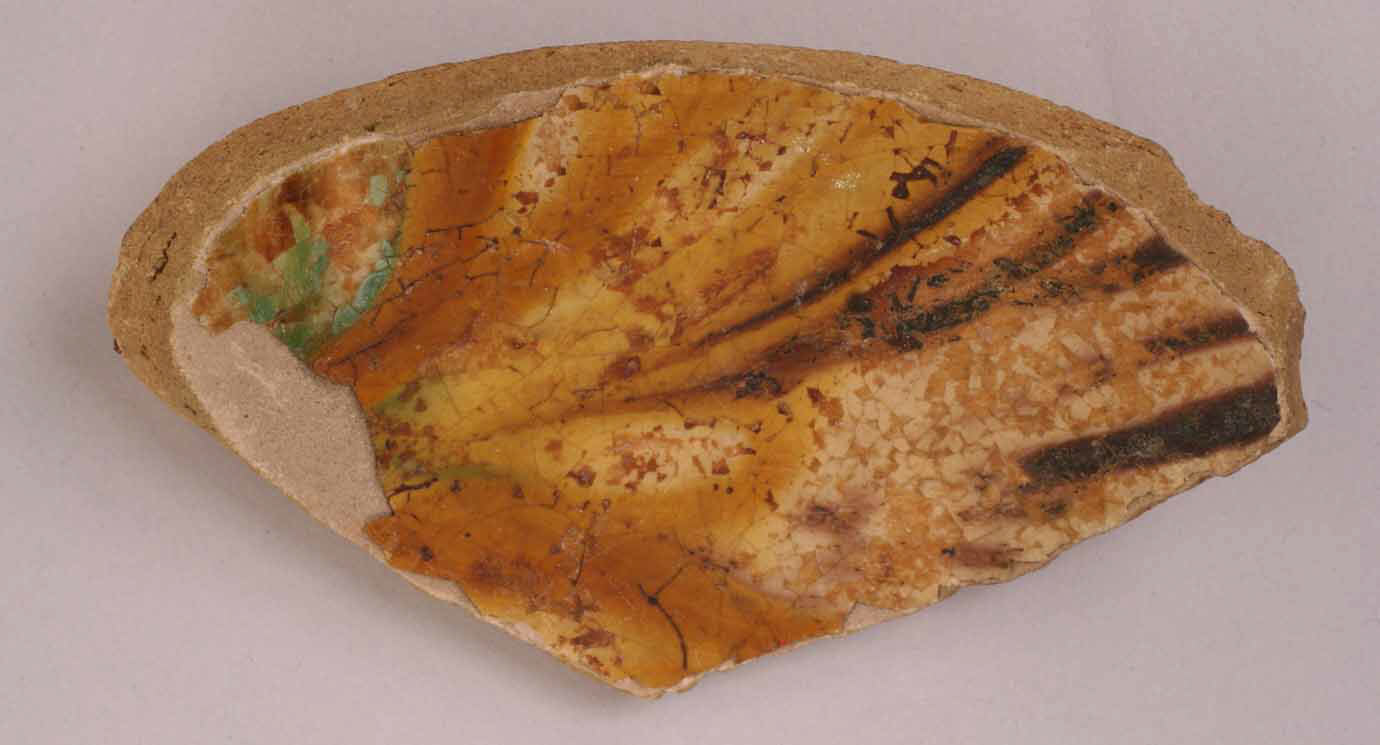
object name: fragment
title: Ceramic Fragment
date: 701-900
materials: earthenware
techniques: glazing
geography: iraq